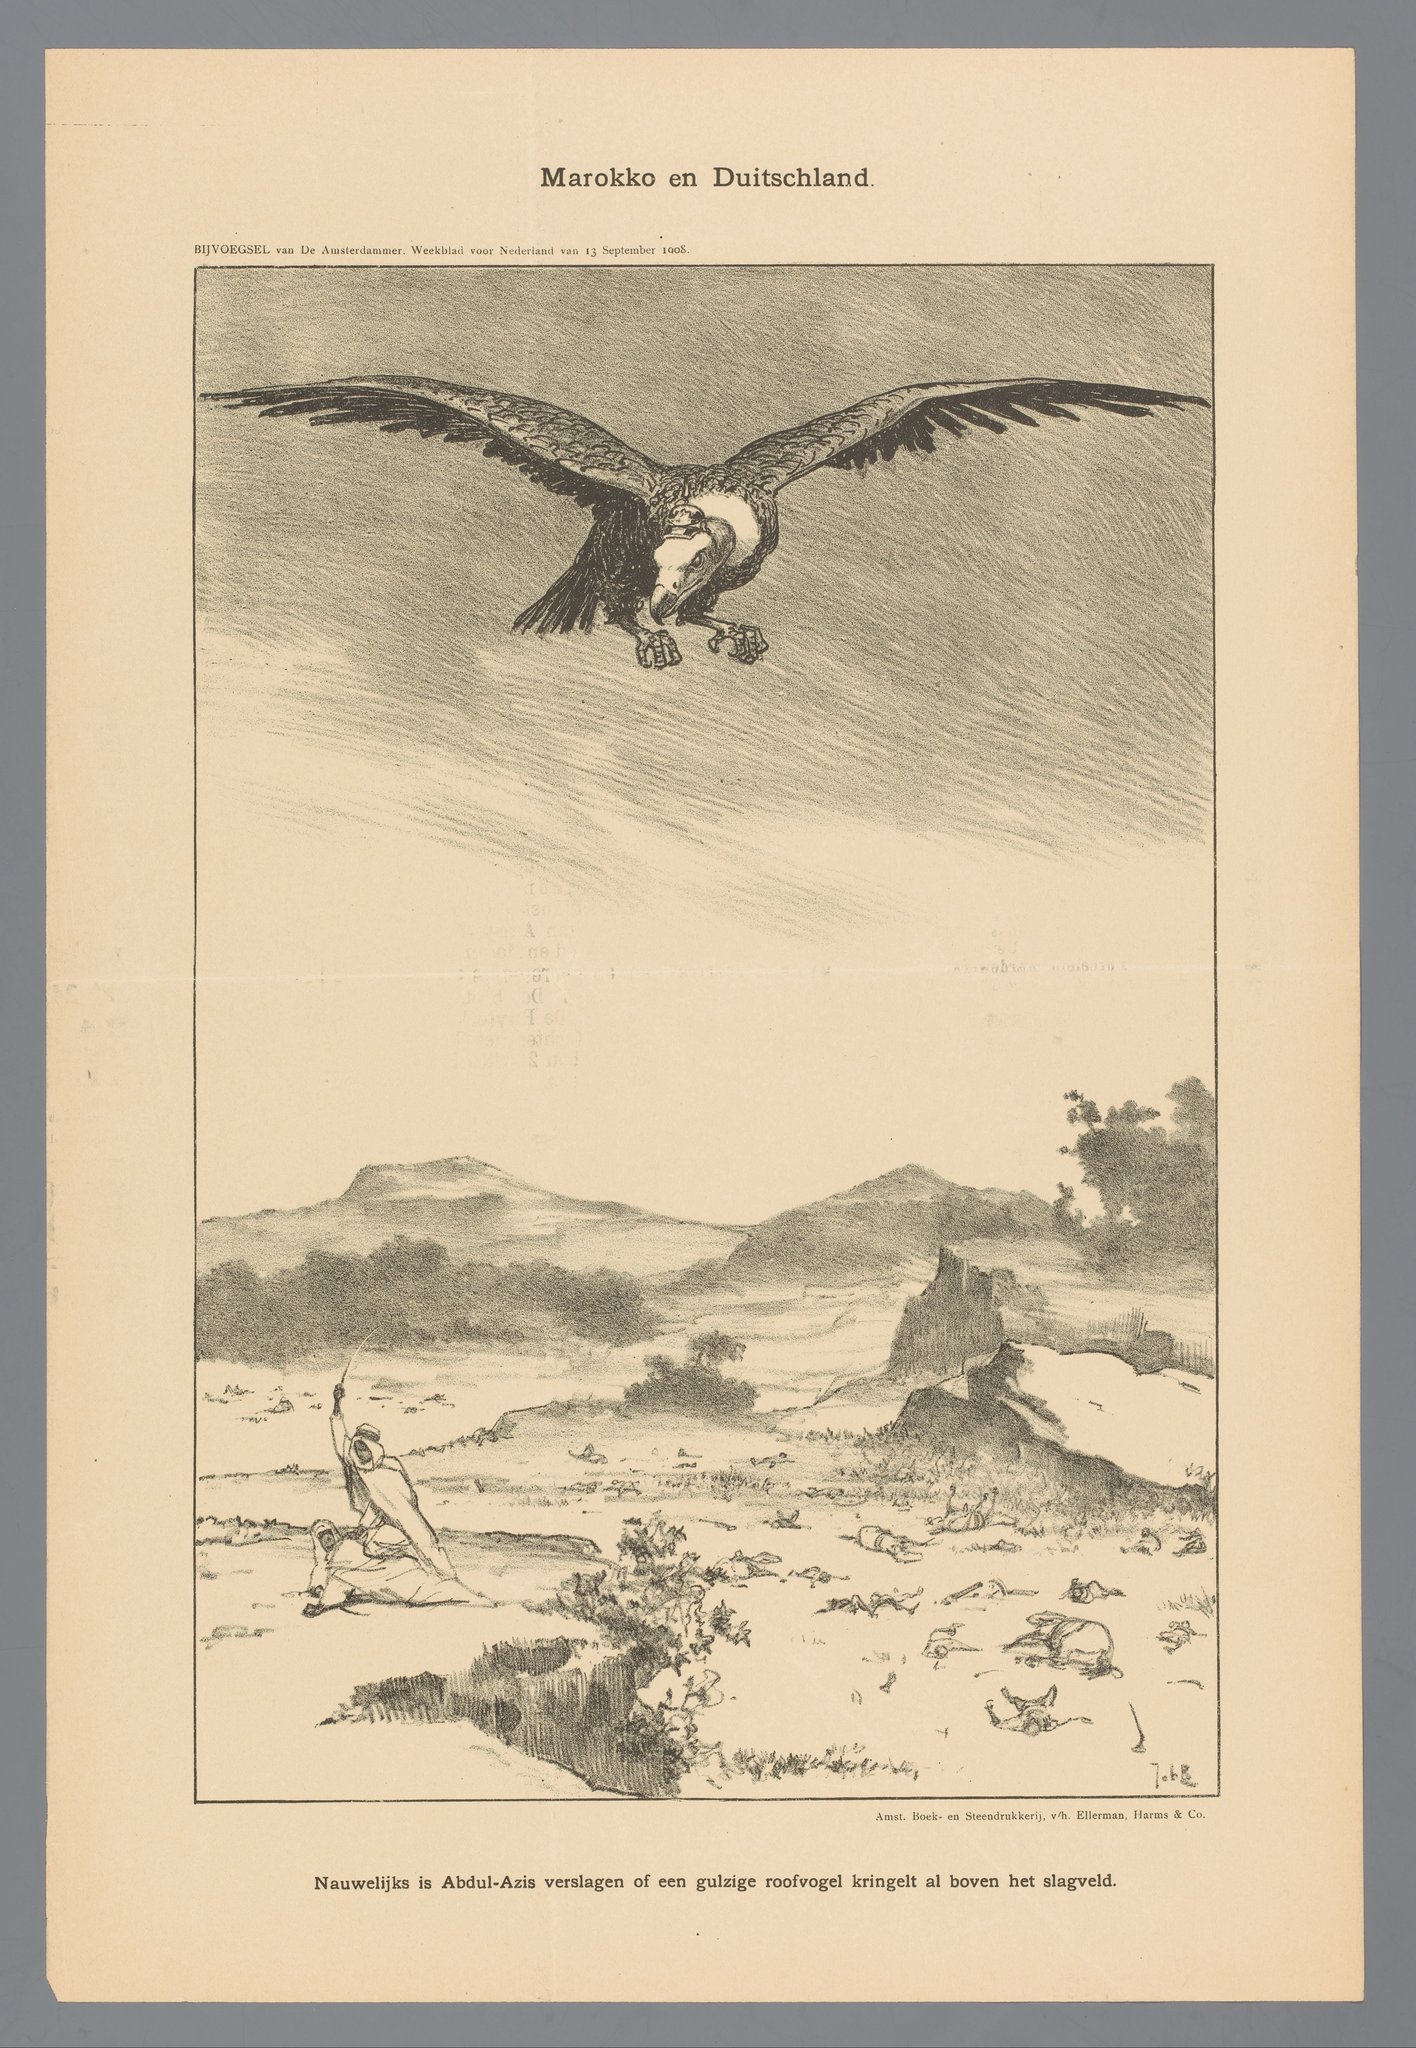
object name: cartoon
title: Marokko en Duitschland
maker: johan braakensiek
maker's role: draughtsman, print maker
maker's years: 1858-1940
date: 1908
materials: paper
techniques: lithograph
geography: amsterdam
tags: predatory birds: vulture, war, political caricatures and satires, germany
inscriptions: date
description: Prent uit het bijvoegsel van: De Amsterdammer. Weekblad voor Nederland, 13 september 1908.